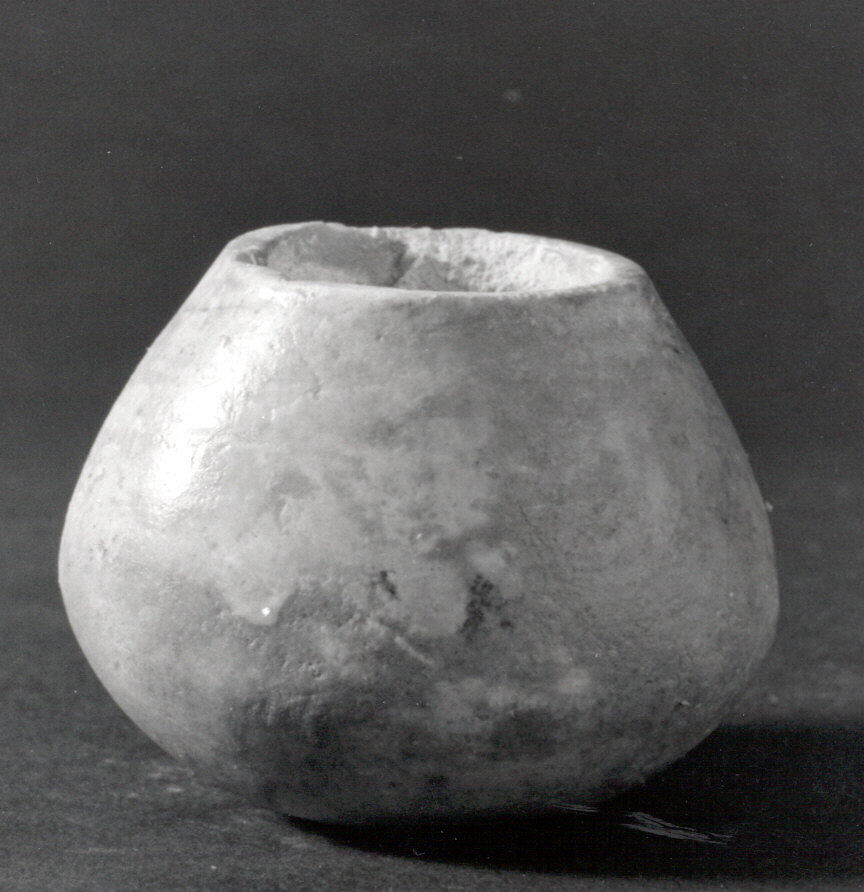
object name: vessel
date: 7000-5001 BCE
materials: limestone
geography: syria